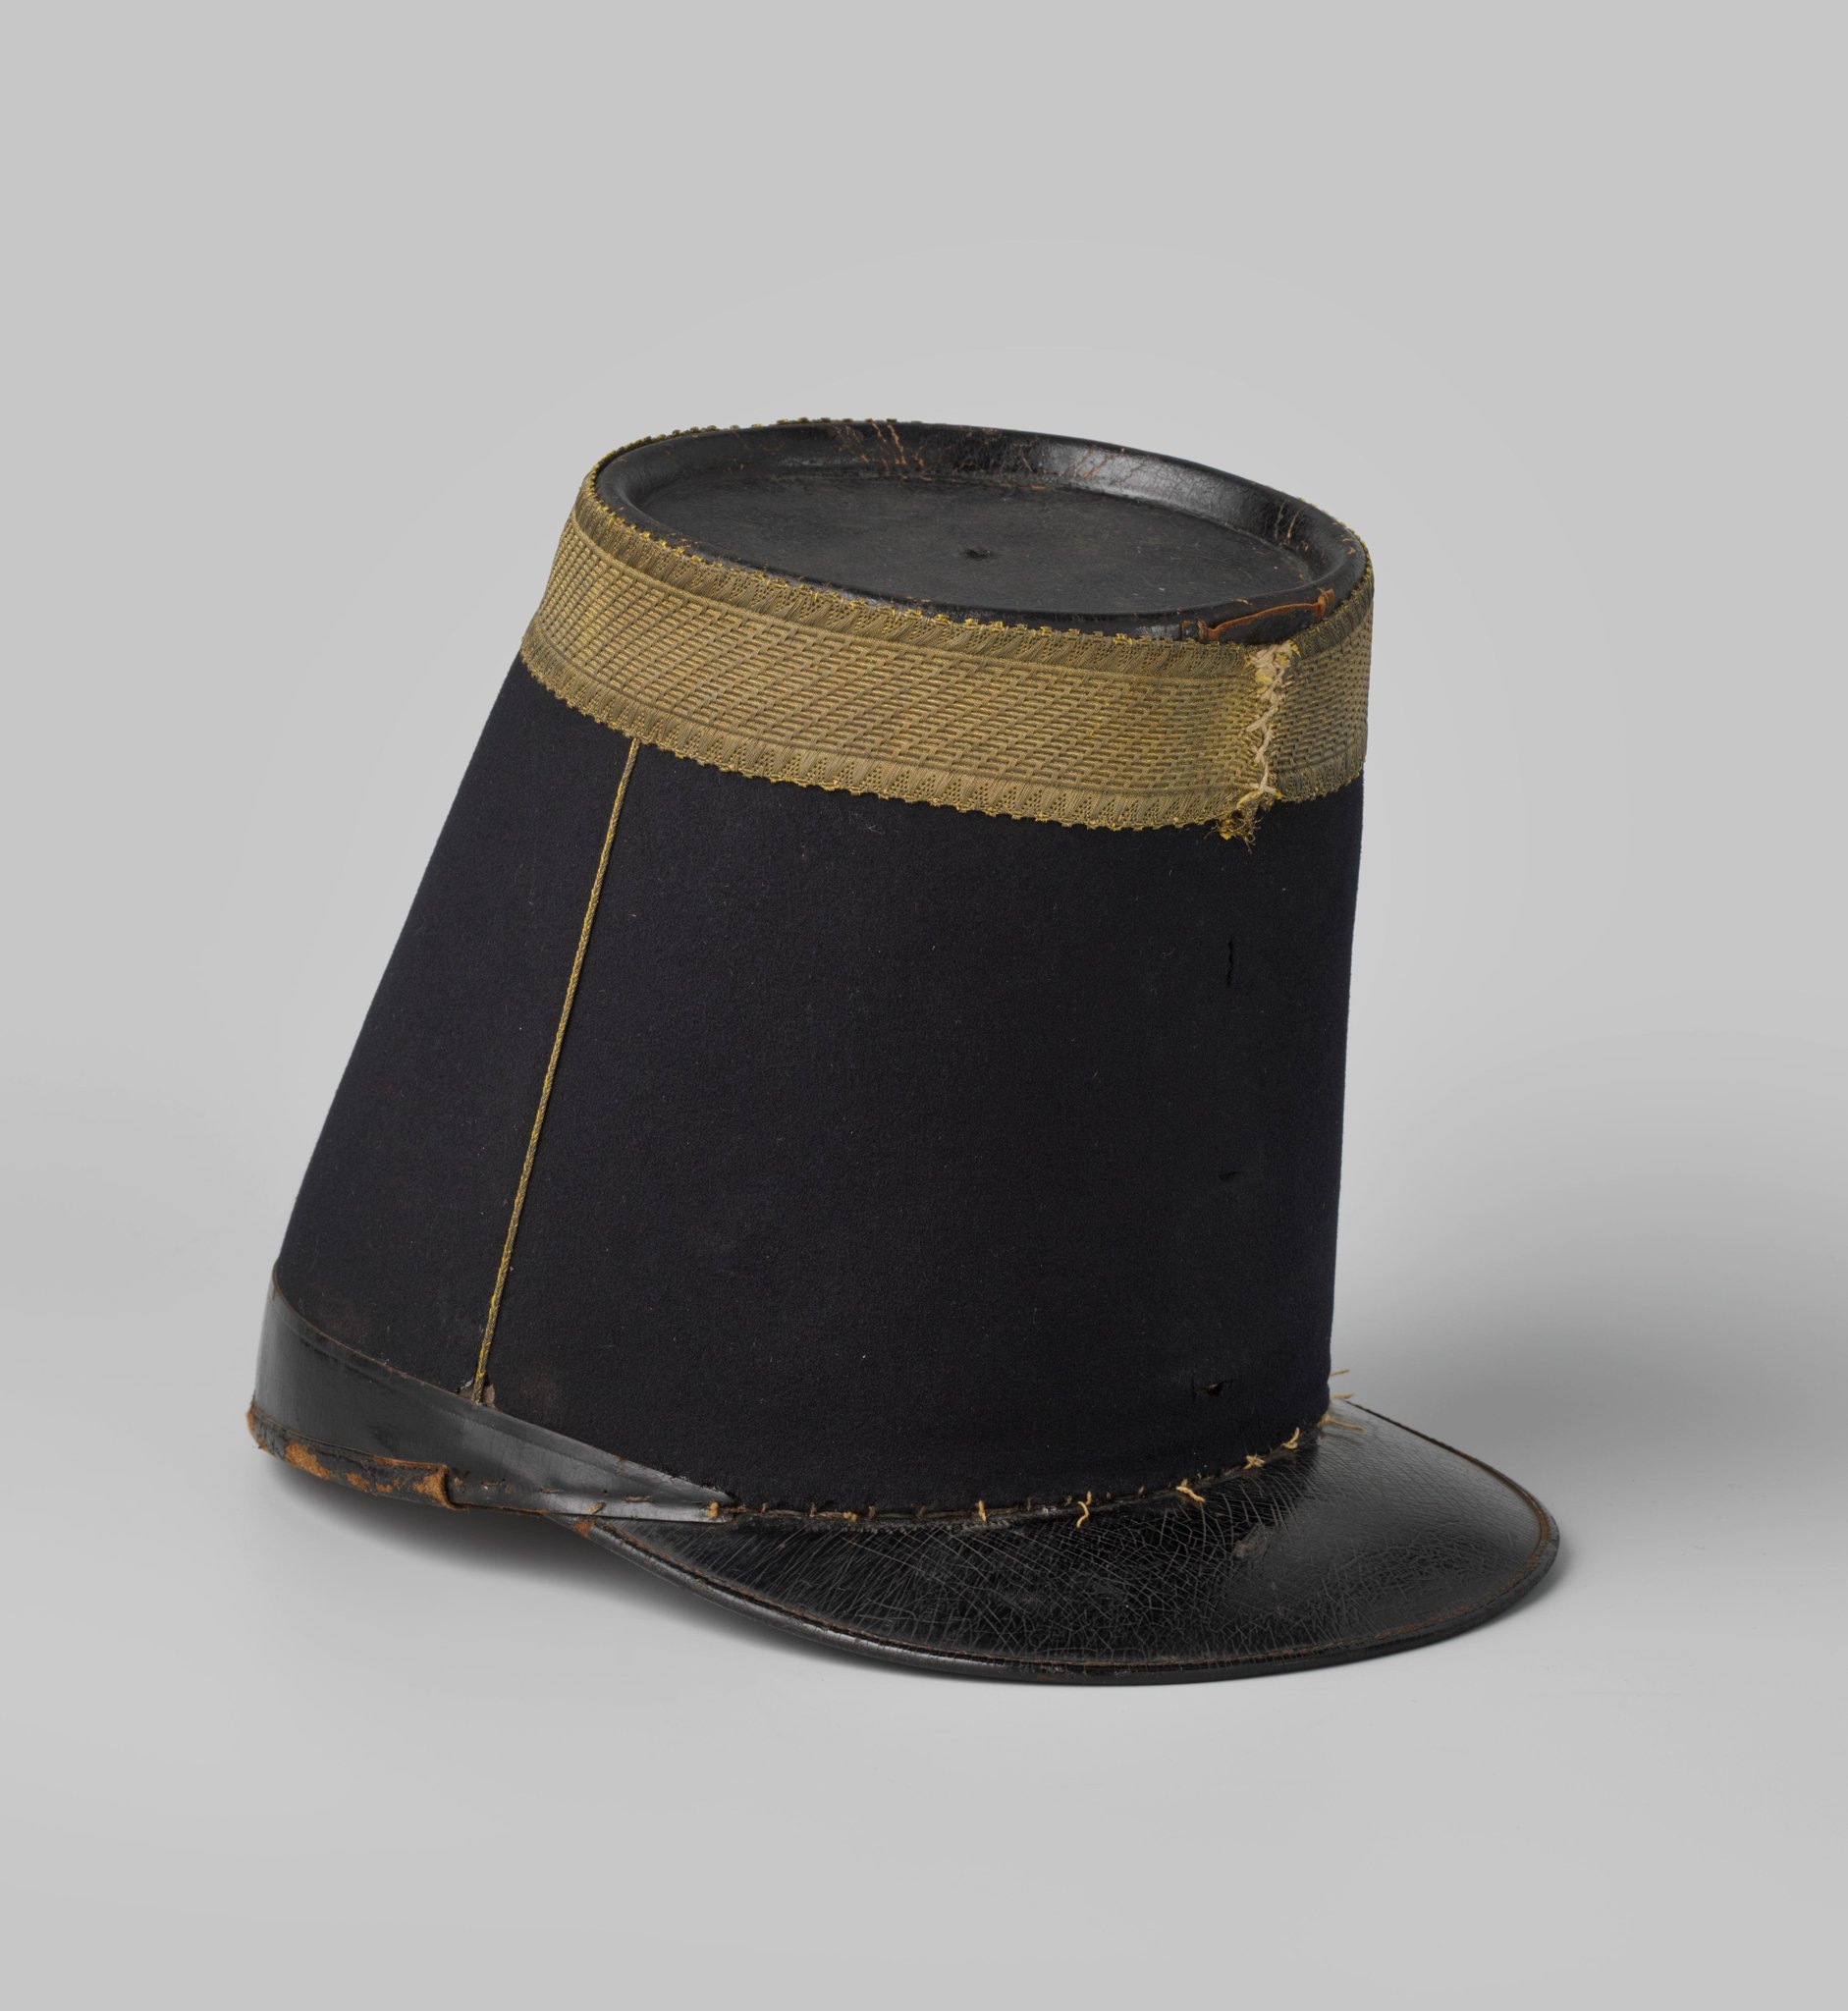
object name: shako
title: Sjako officier infanterie, M.1854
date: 1854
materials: textile, gold leaf, gold thread, leather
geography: breda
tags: netherlands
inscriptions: inscription: ‘J.F. Seegers - Groote Markt 32, Breda’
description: Hoofddeksel van blauw laken, zwarte lakleren bodem, rand, klep om bodem goudgalon, drie verticale gouden biezen. Binnenwerk: rood leren zweetband, op bodem leren draaglus in tekst in goud op snee: J.F. Seegers - Groote Markt 32, Breda.